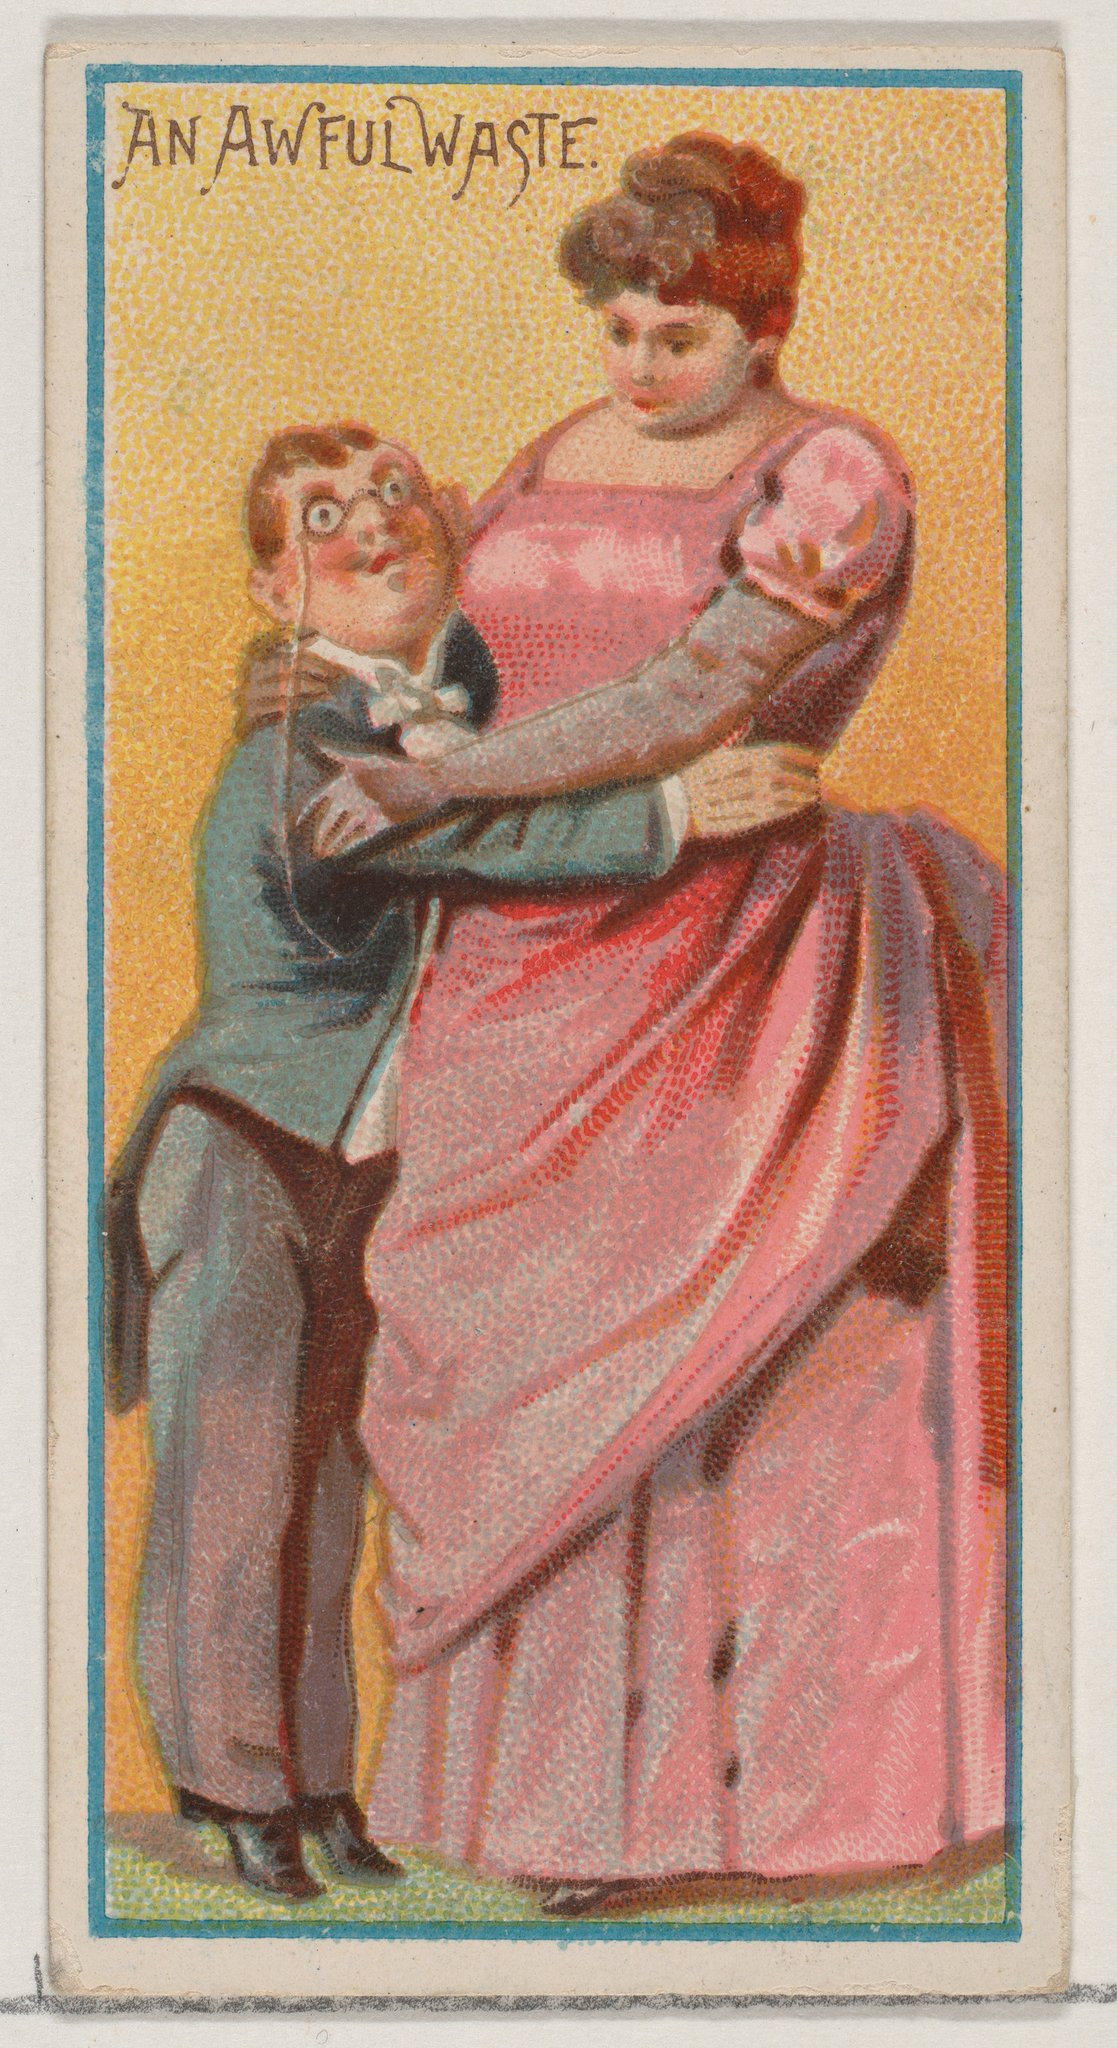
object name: print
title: An Awful Waste, from the Jokes series (N87) for Duke brand cigarettes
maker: w. duke, sons & co.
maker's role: publisher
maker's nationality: american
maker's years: 1870-1920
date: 1890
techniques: color lithograph